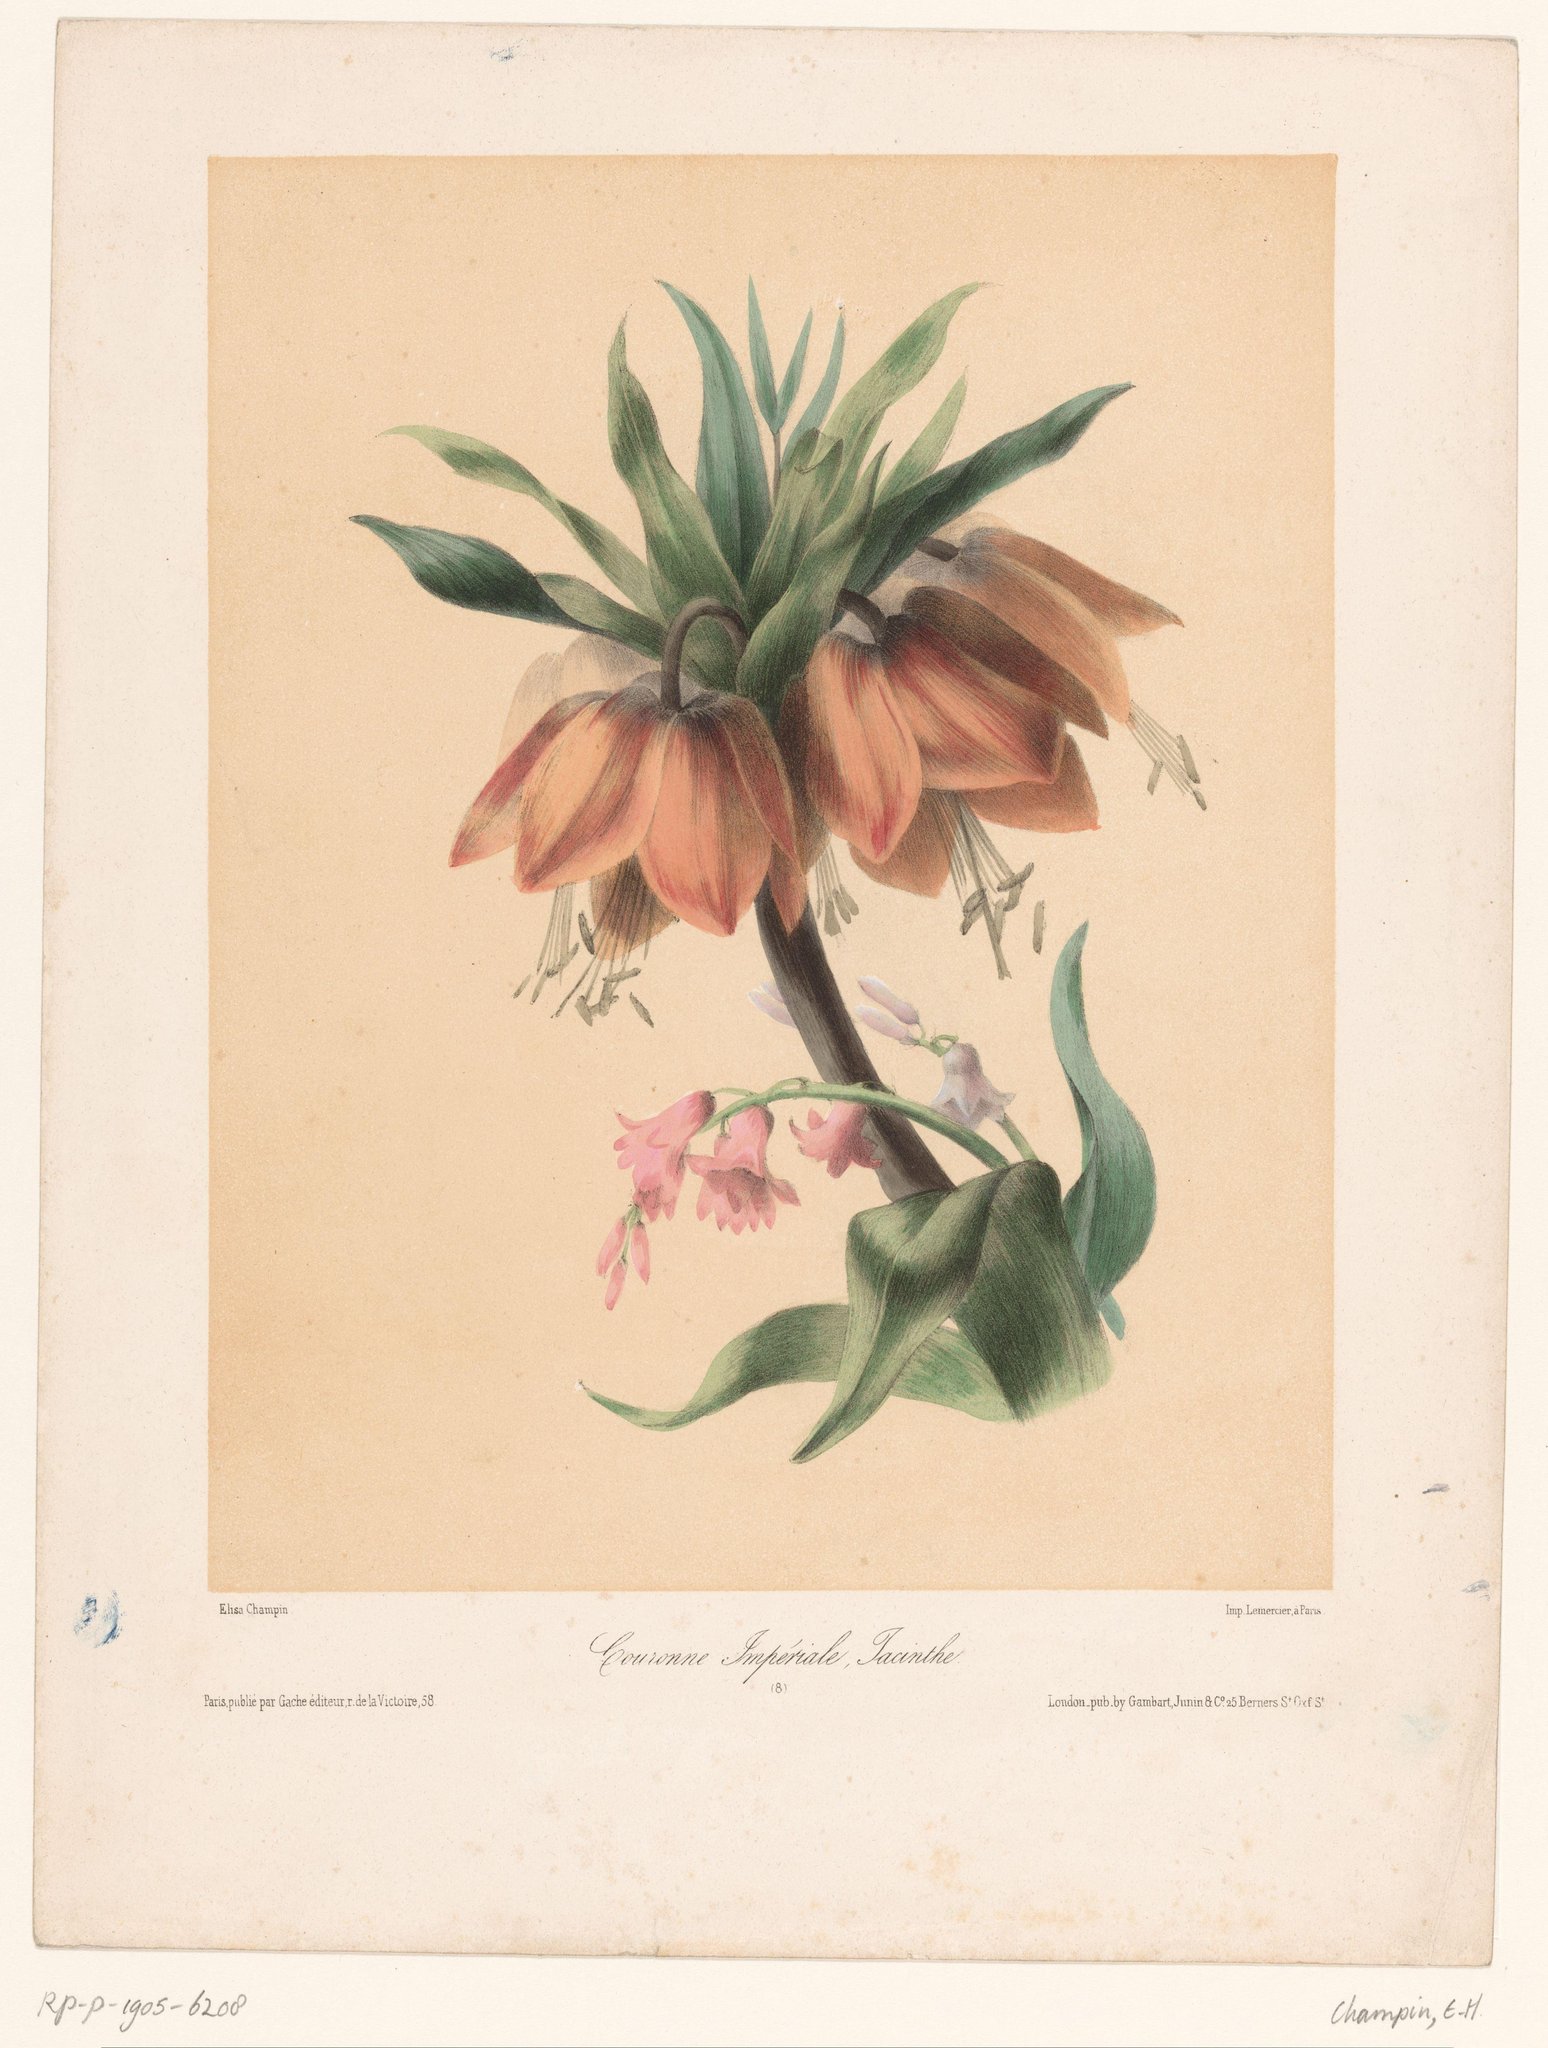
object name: print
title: Keizerskroon en Hyacint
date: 1841-1857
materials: paper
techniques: tone lithography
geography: london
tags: flowers, flowers: hyacinth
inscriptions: collector's mark: Lugt 2228a